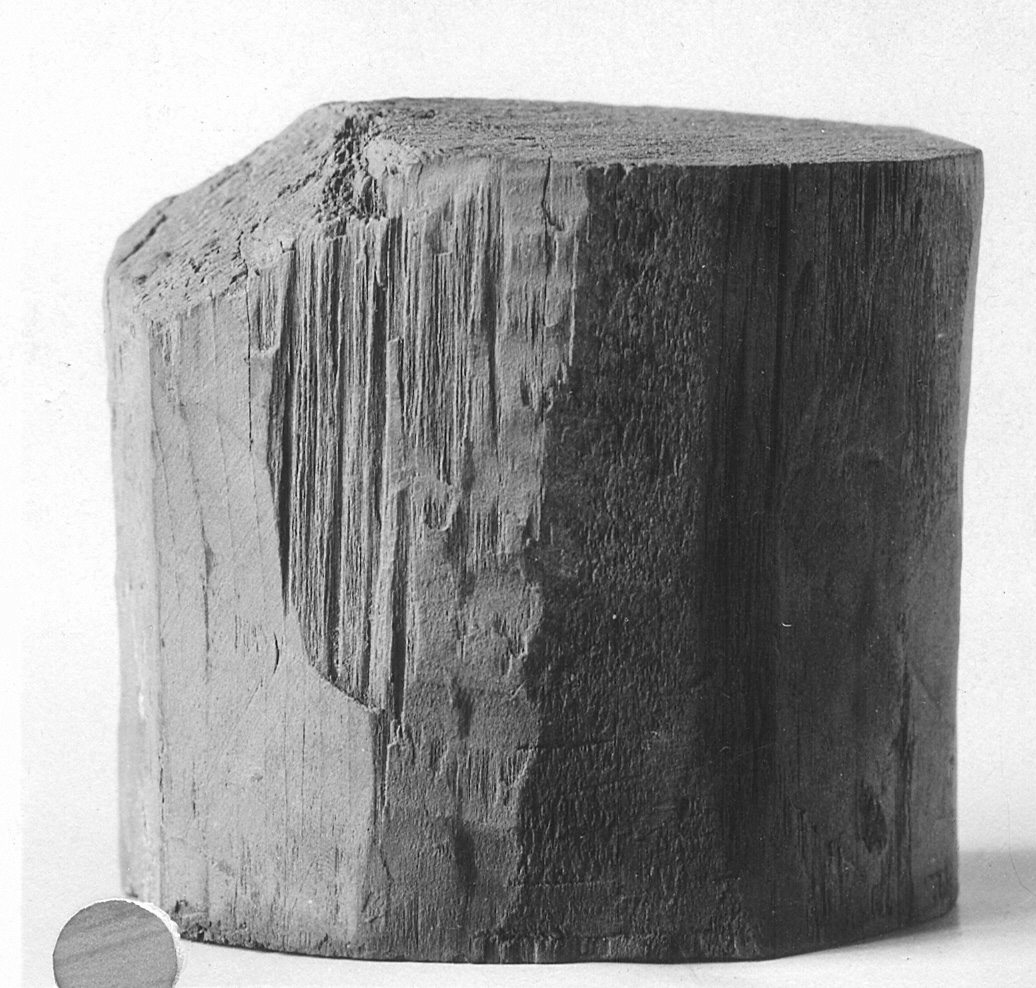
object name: coffin knob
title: Knob from Wah's Coffin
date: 1981-1975 BCE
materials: plaster, wood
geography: egypt